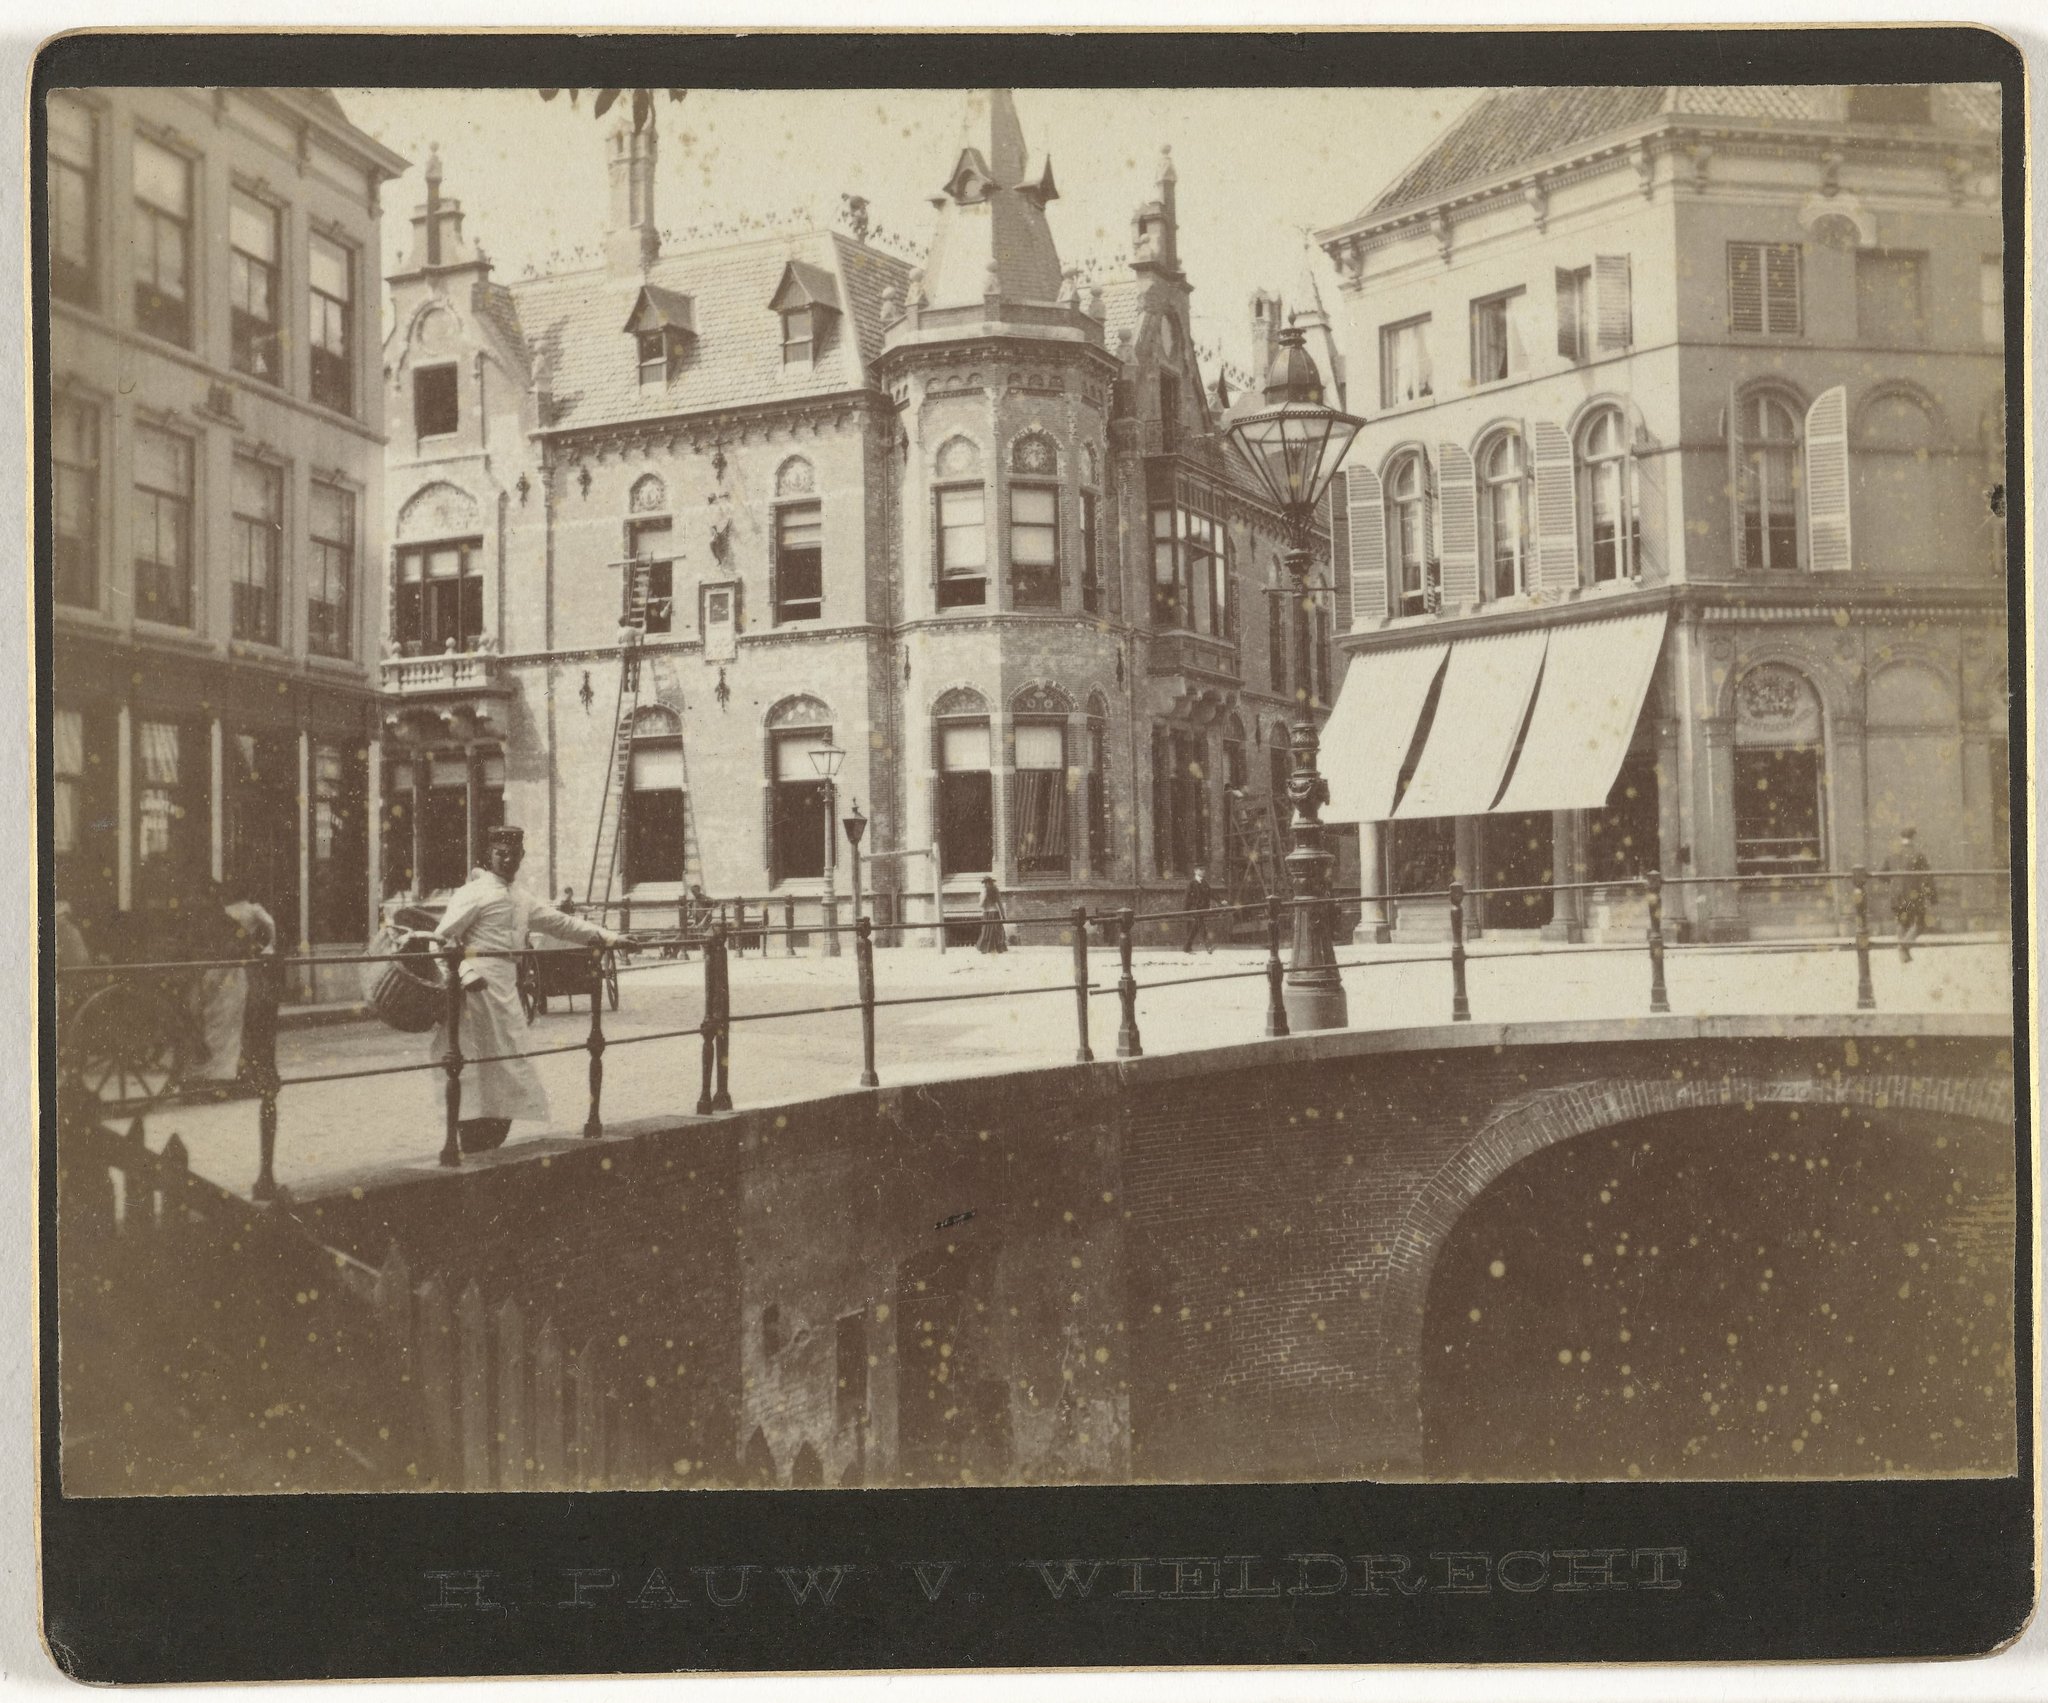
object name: photograph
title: Gezicht in Utrecht: hoek Nieuwe Gracht, Trans, Pausdam en Achter den Dom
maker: henry pauw van wieldrecht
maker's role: fotograaf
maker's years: 1863-1912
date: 1891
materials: cardboard, photographic support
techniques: albumen print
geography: netherlands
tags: nieuwe gracht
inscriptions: signature: ‘H. PAUW V. WIELDRECHT’, annotation: ‘No. 52. 397. 1891.’